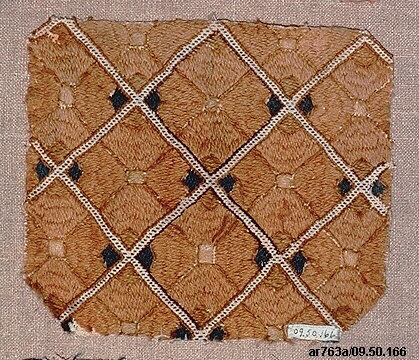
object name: costume fragment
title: Peasant costume fragment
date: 1701-1900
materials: canvas, wool